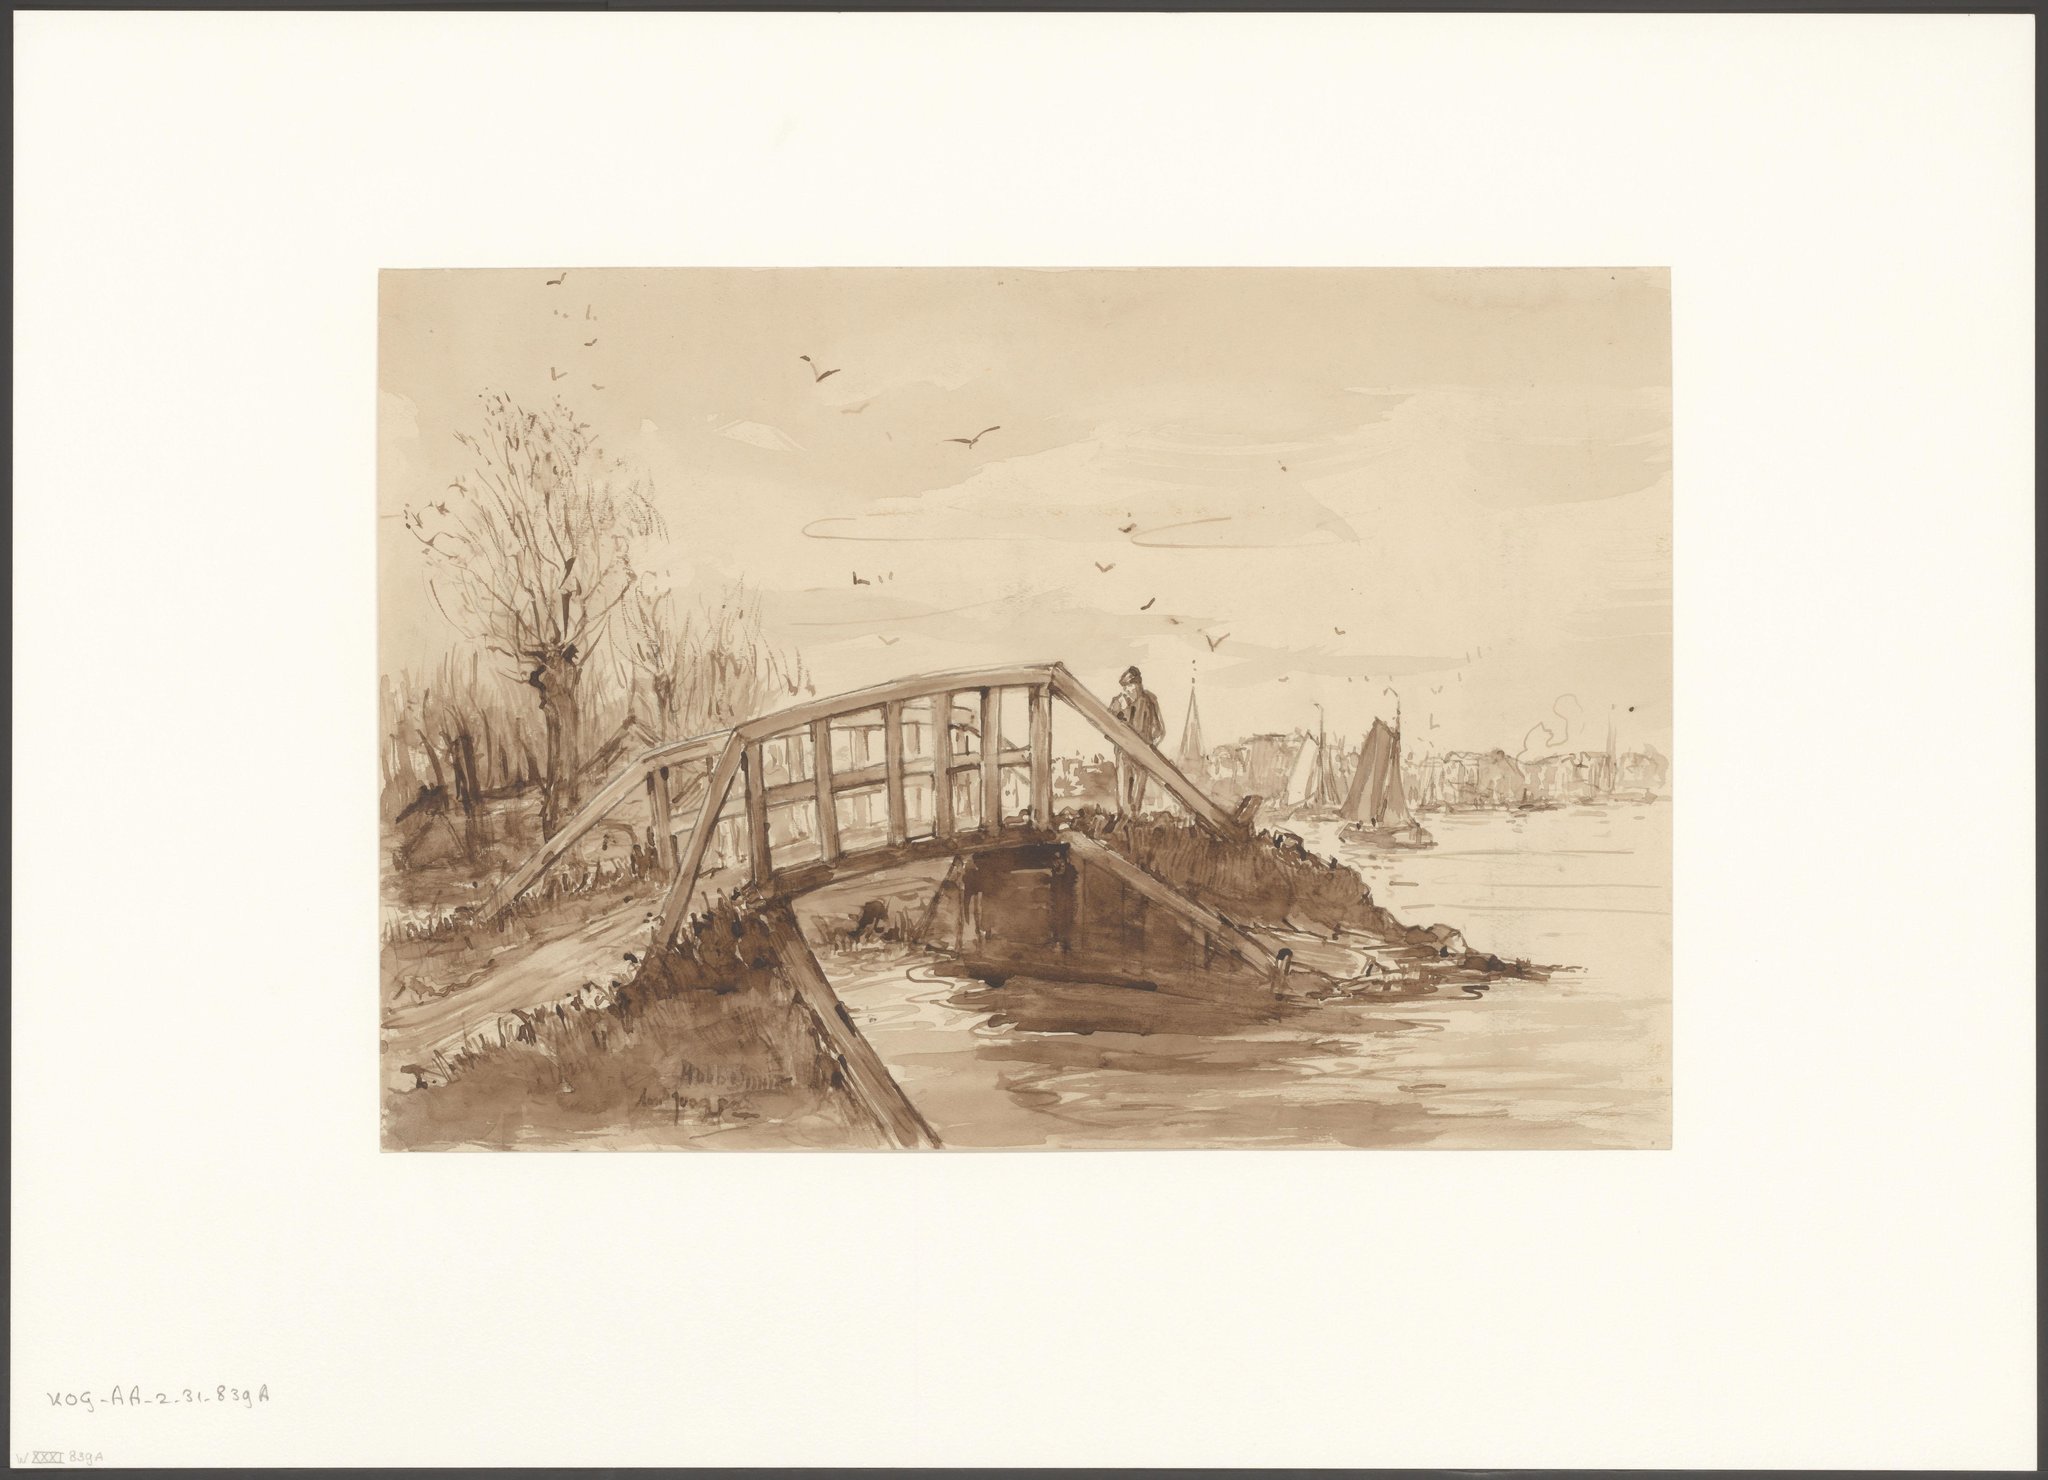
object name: drawing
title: Gezicht op een brug over de Schinkel, gezien vanaf het Jaagpad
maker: hobbe smith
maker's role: painter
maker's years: 1862-1942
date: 1872-1942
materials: ink, paper, pencil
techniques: brush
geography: amsterdam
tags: sailing-ship, sailing-boat, city-view in general; 'veduta', canal, bridge in city across river, canal, etc.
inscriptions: collector's mark: Lugt 800a, inscription: ‘Het 1ste Bruggetje in het Jaagpad / langs den Schinkel’, inscription: ‘Aan Jaagpad’, signature: ‘HobbeSmith’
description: Tekening binnen de Atlas Van Eck ingedeeld op wijknummer 31.